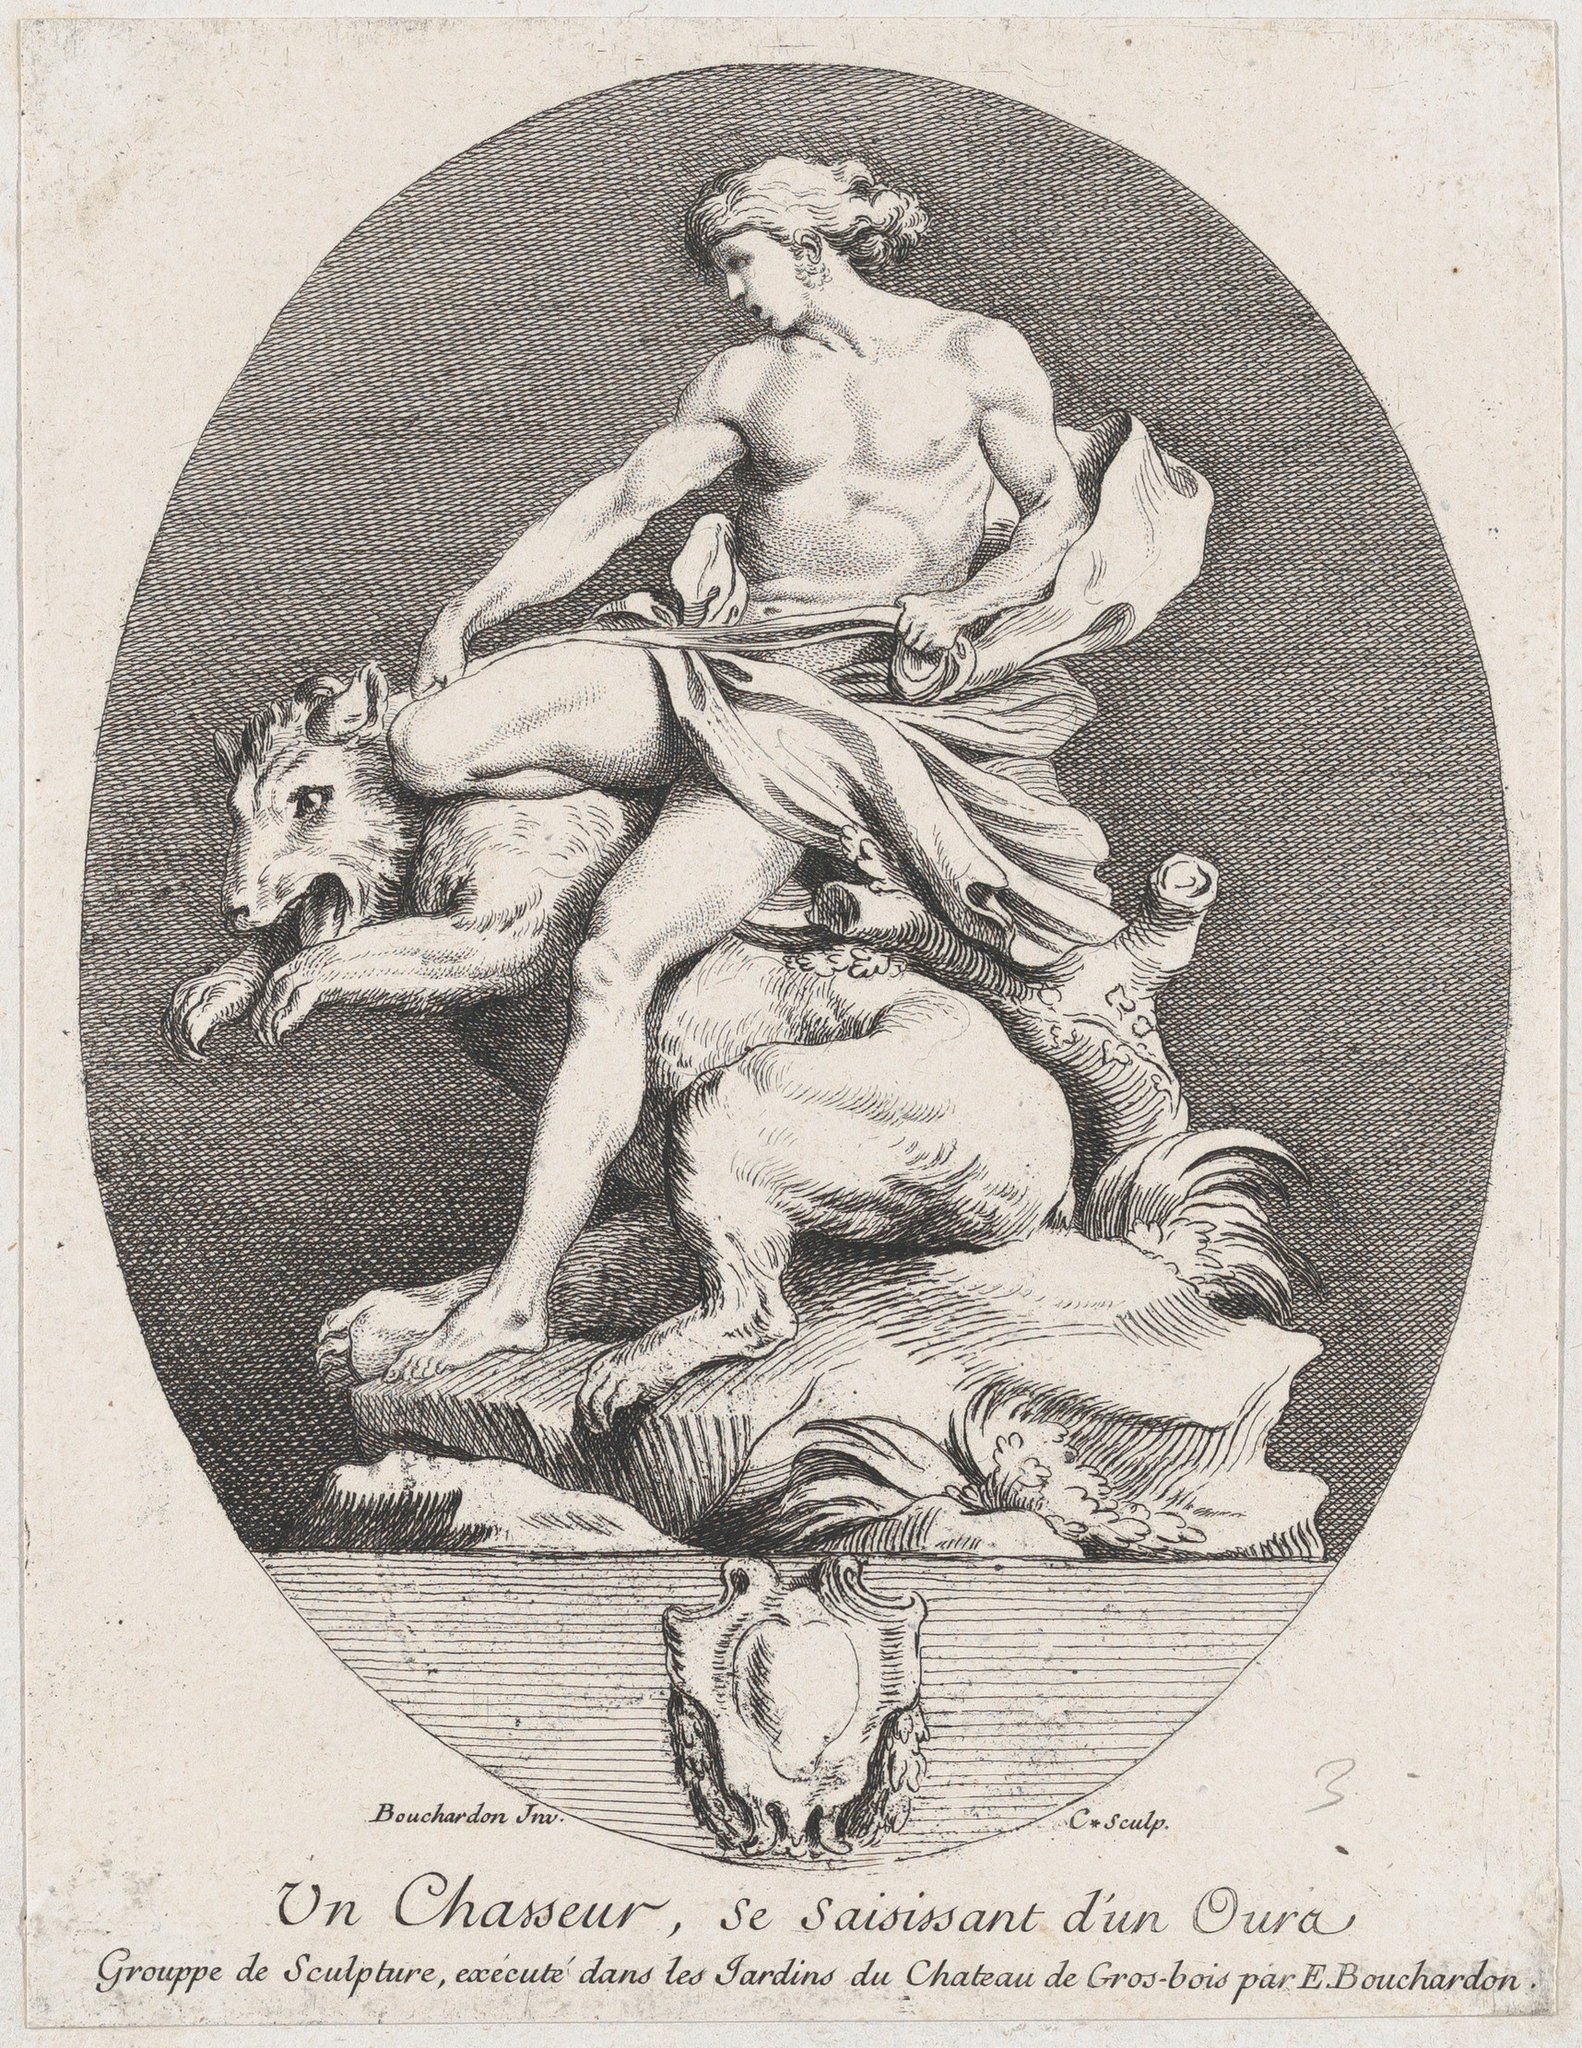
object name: print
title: A Hunter Grabbing a Bear, from "Group of Subjects Drawn From Antiquity"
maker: anne claude philippe de tubières, comte de caylus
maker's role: artist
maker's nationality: french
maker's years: 1692-1765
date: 1737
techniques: etching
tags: bears,men,insignia